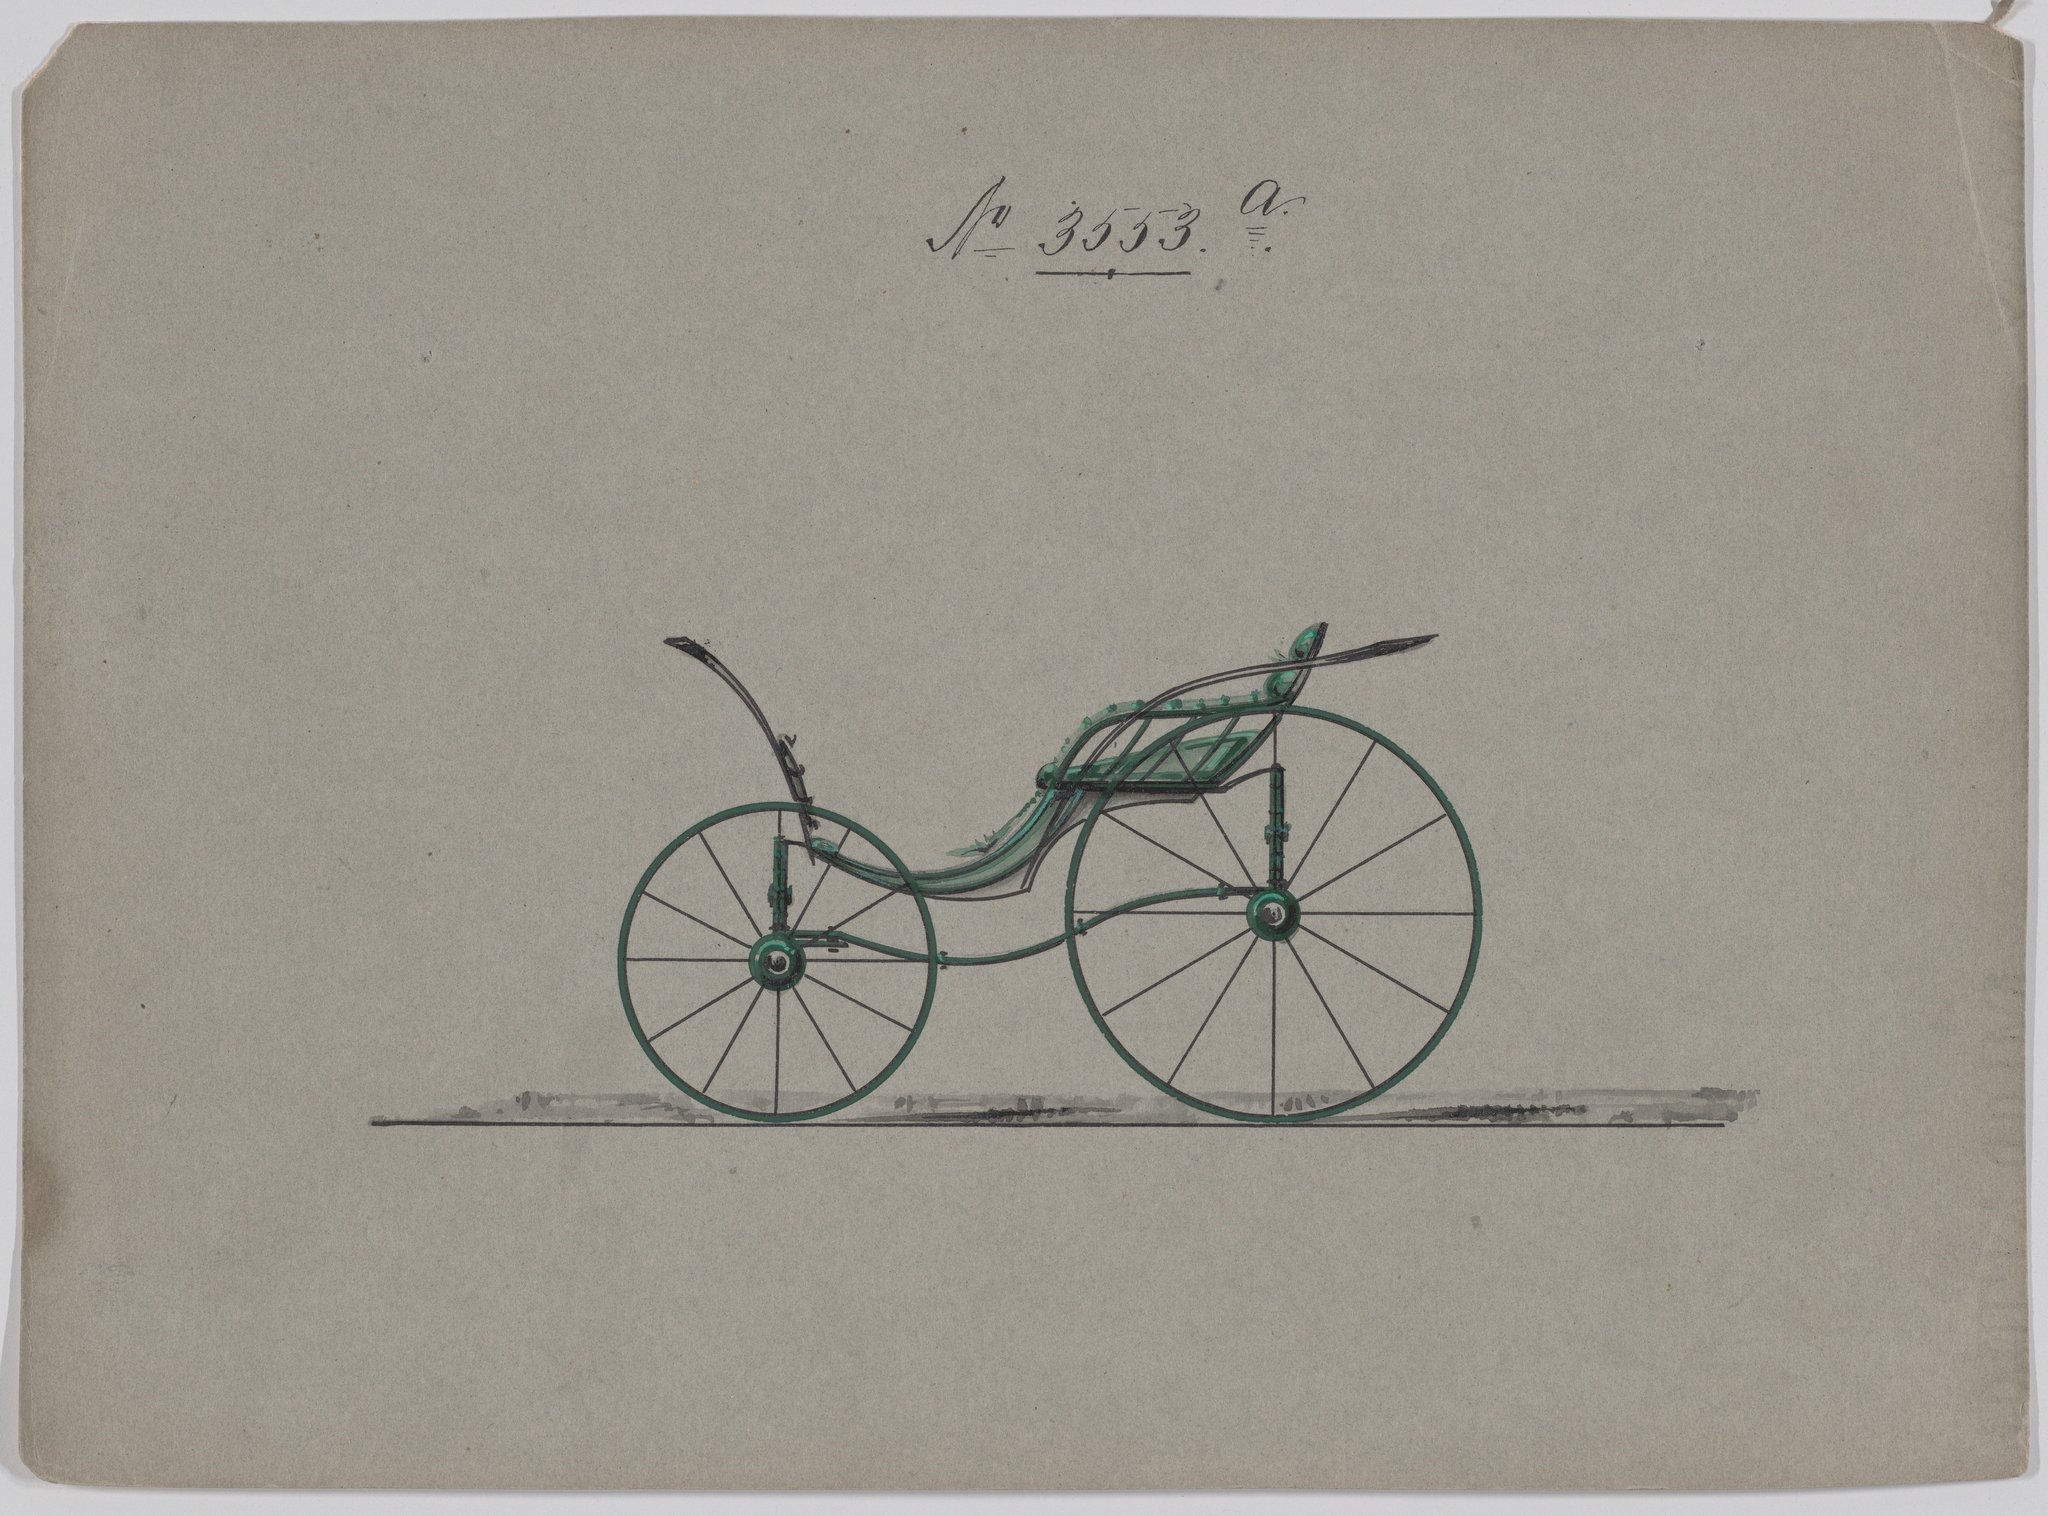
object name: drawing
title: Design for Pony Phaeton, no. 3553a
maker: brewster & co.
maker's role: manufacturer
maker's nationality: american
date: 1879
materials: gouache, gum arabic, ink, watercolor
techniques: pen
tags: carriages